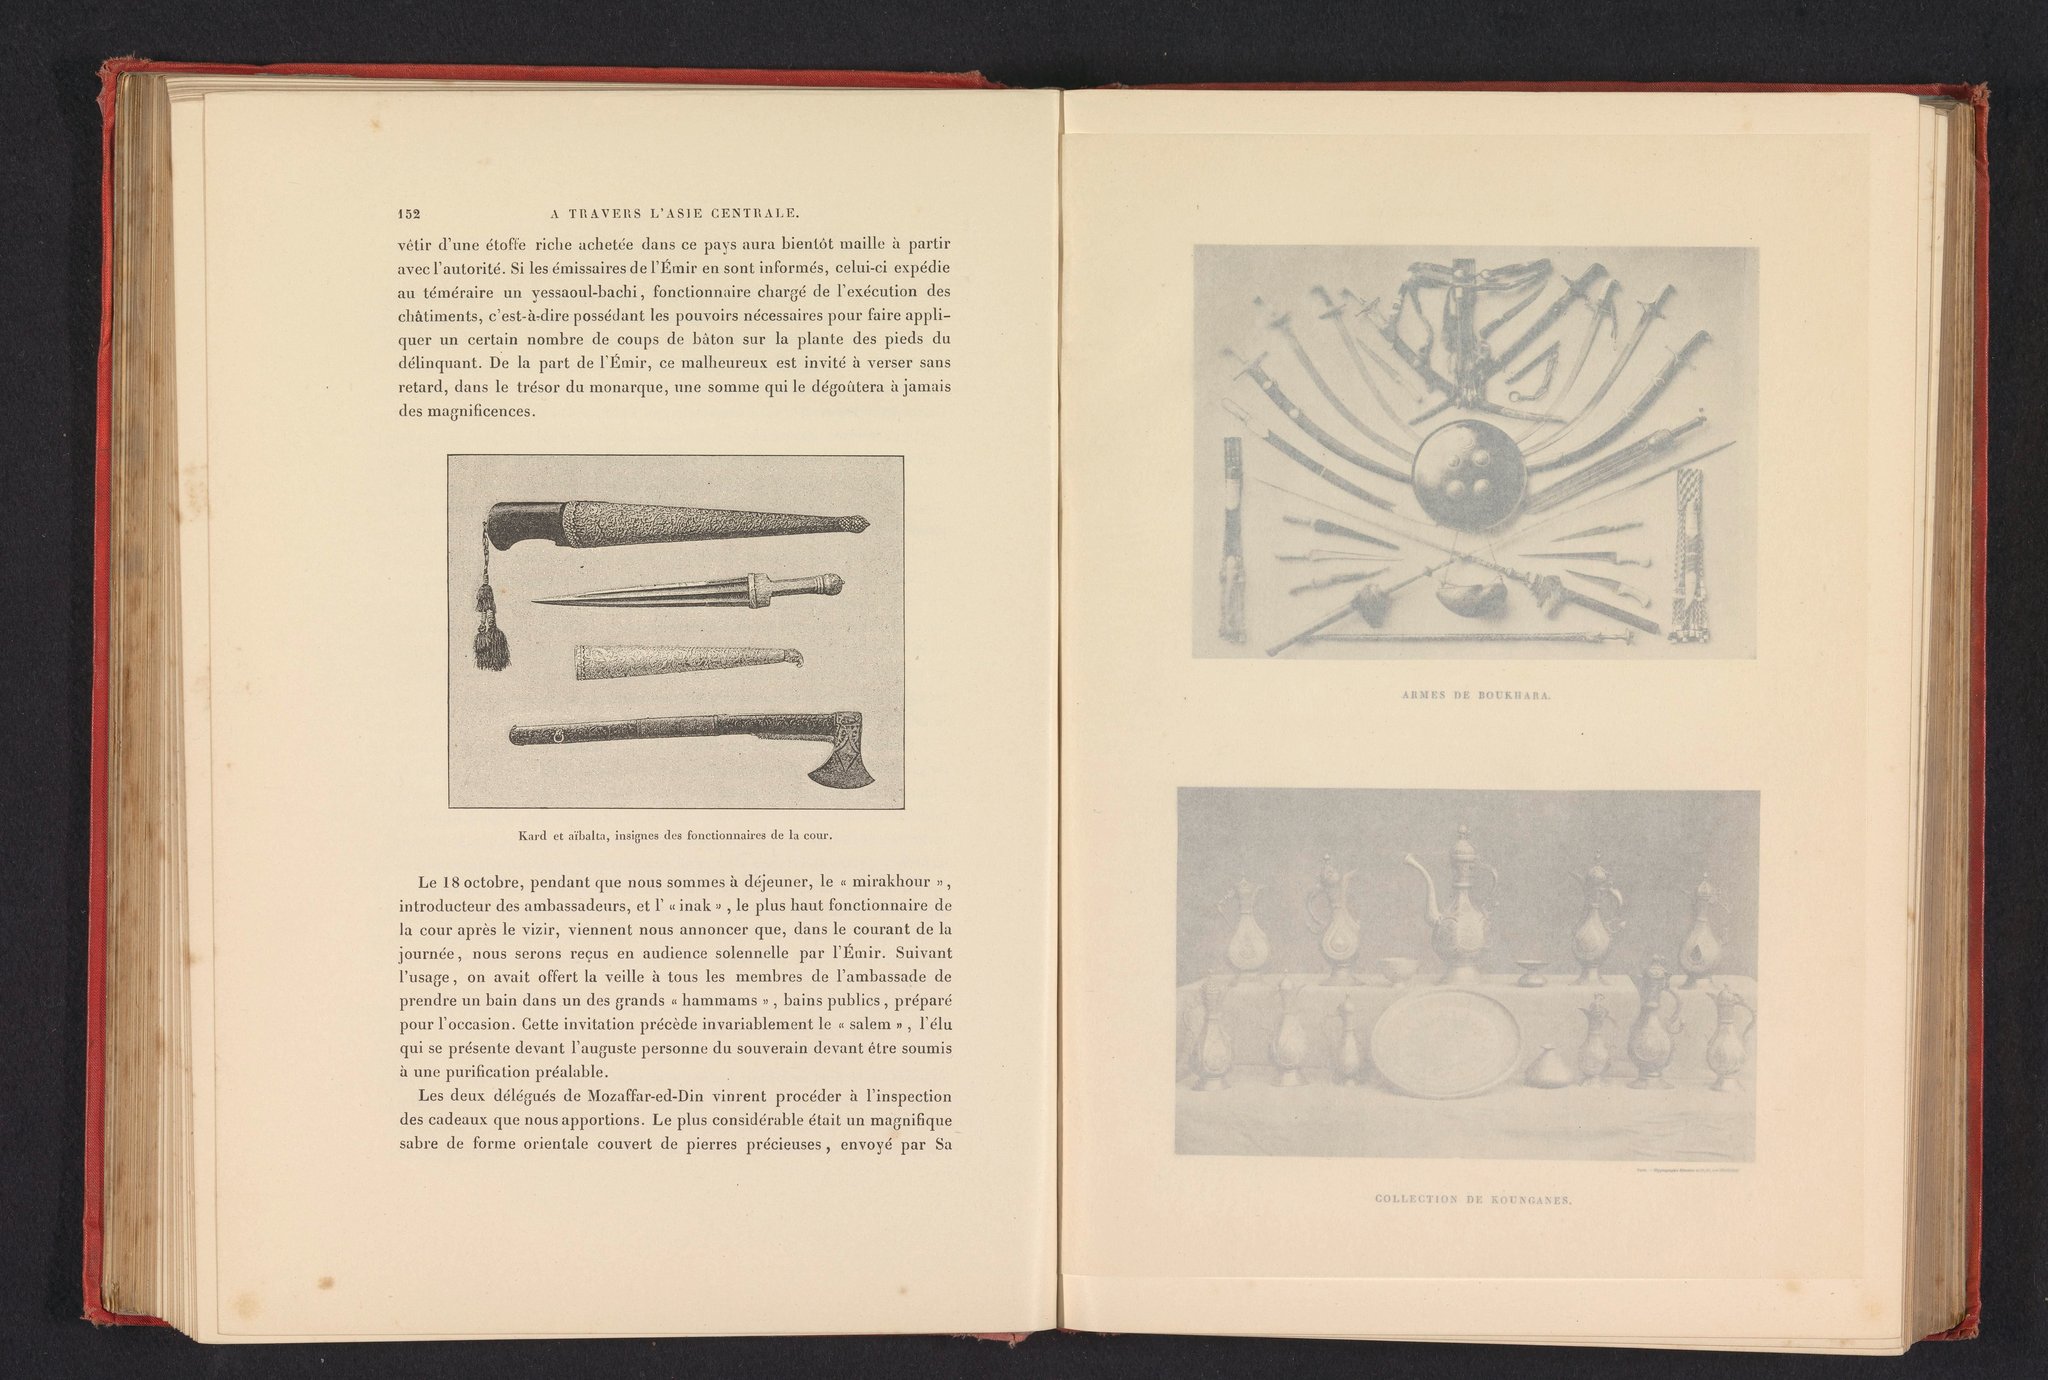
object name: page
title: Dolken en een bijl van medewerkers van een rechtbank in Centraal-Azië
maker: Anonymous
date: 1869-1885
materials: paper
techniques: autotype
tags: weapons